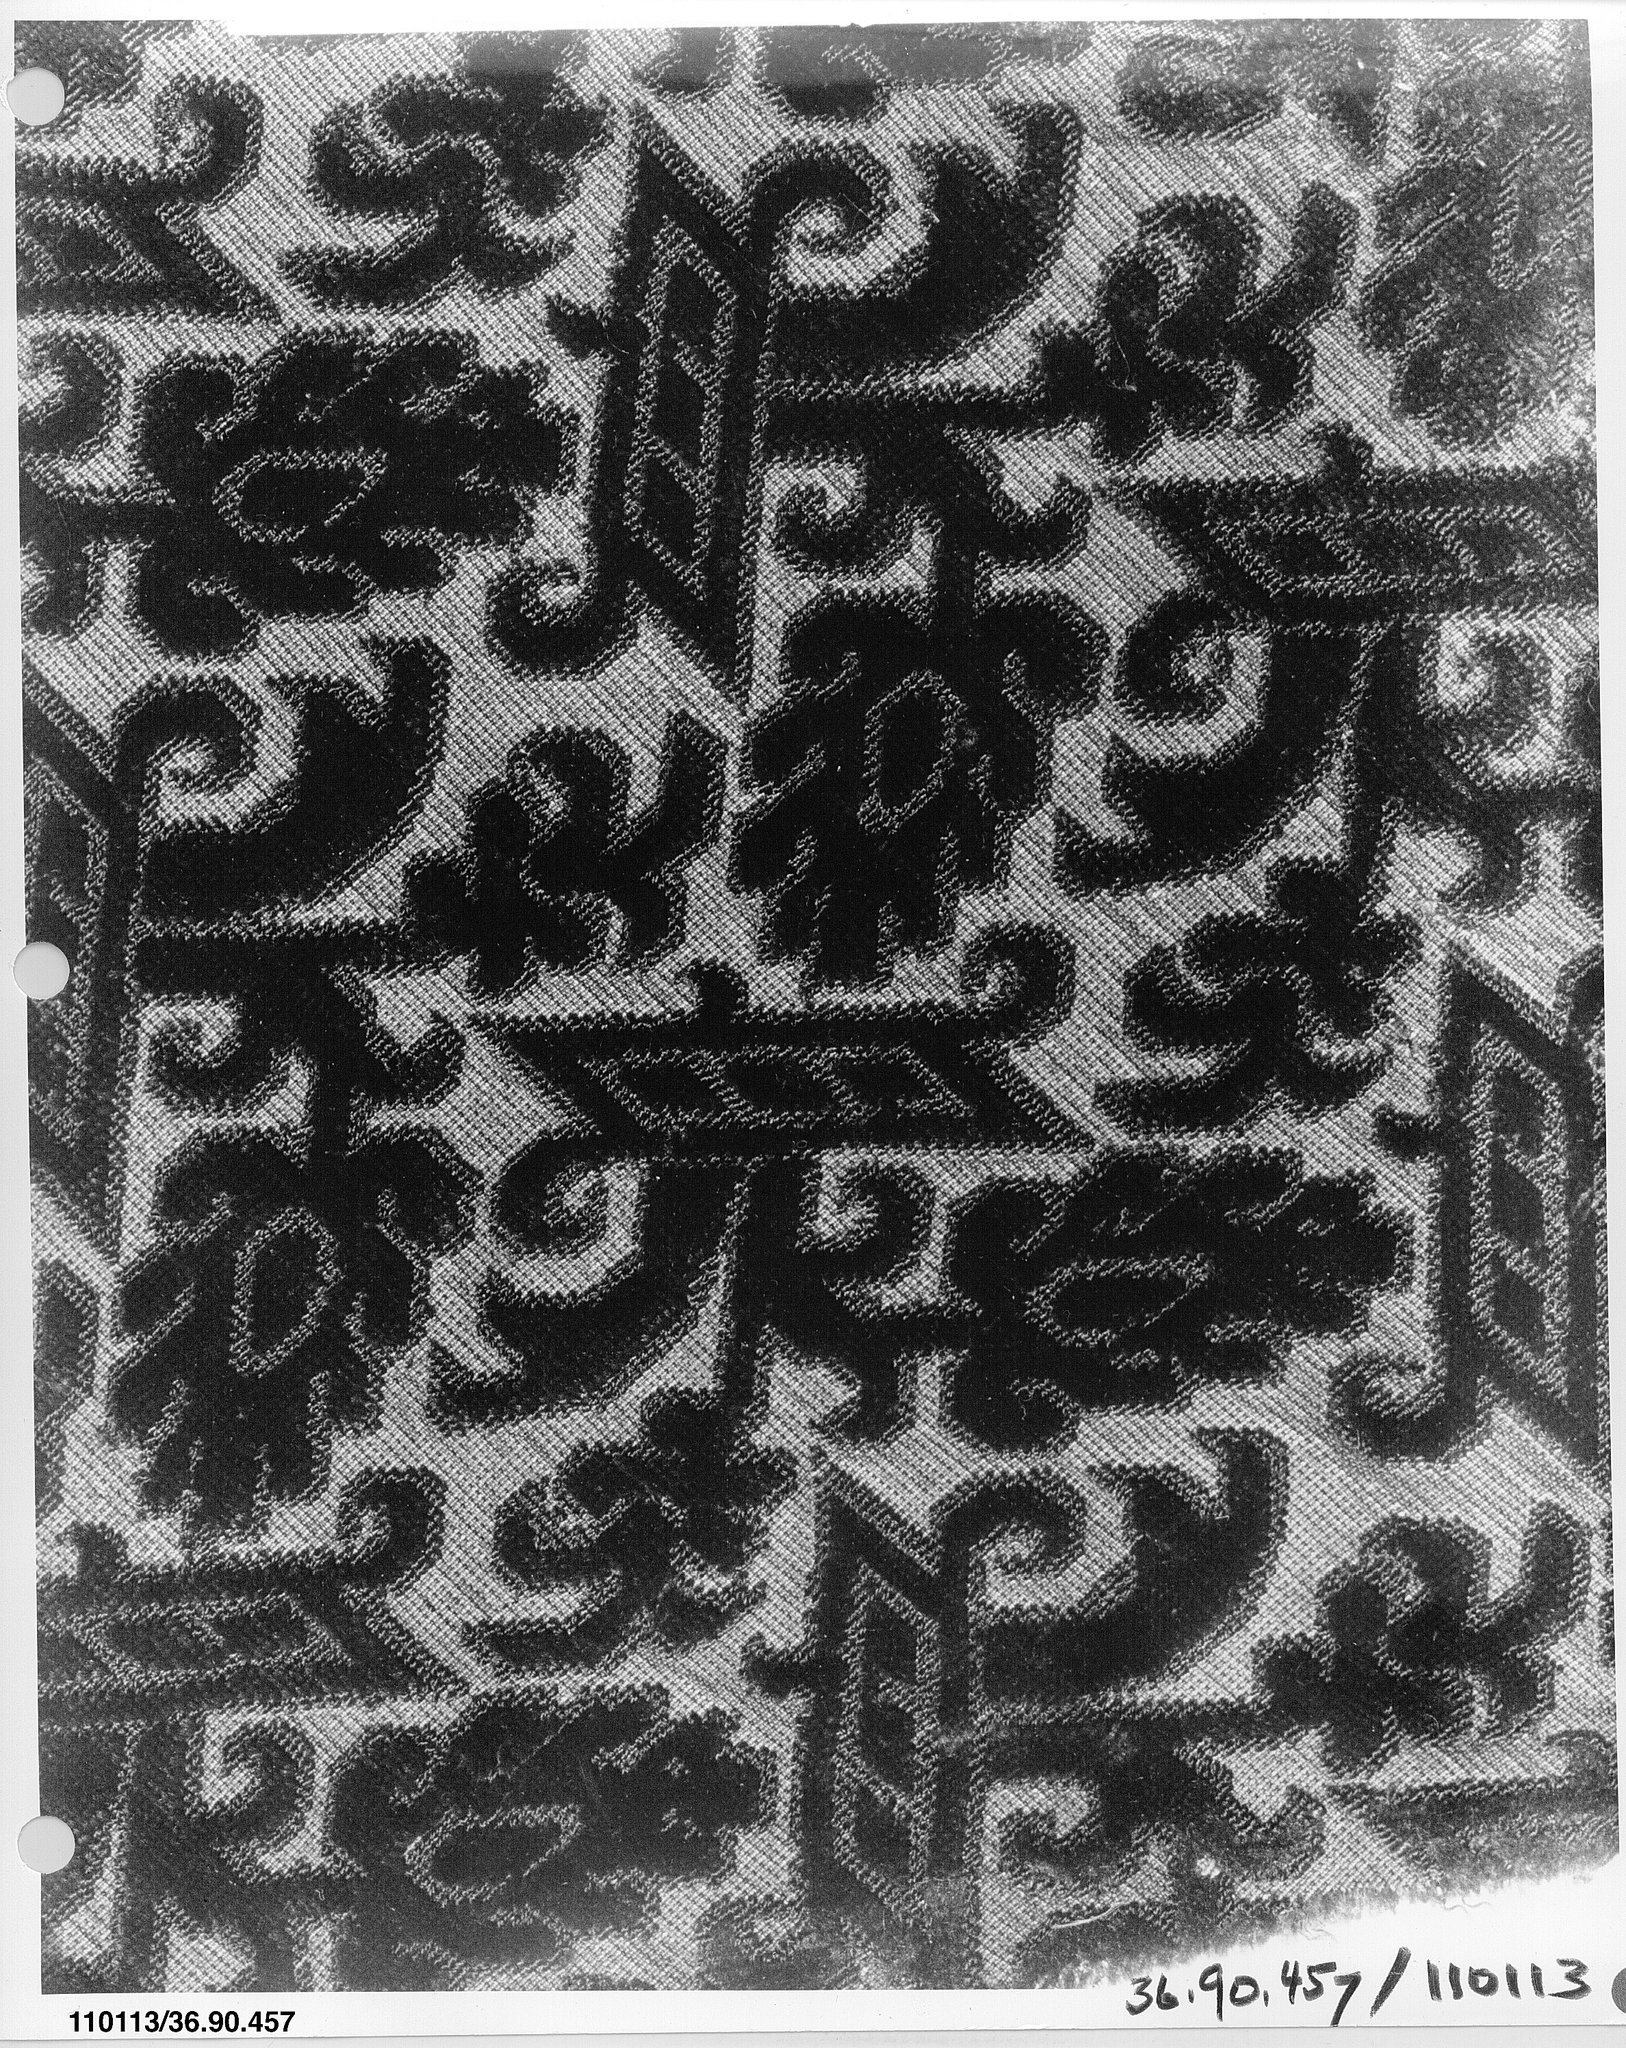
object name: piece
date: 1501-1700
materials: silk